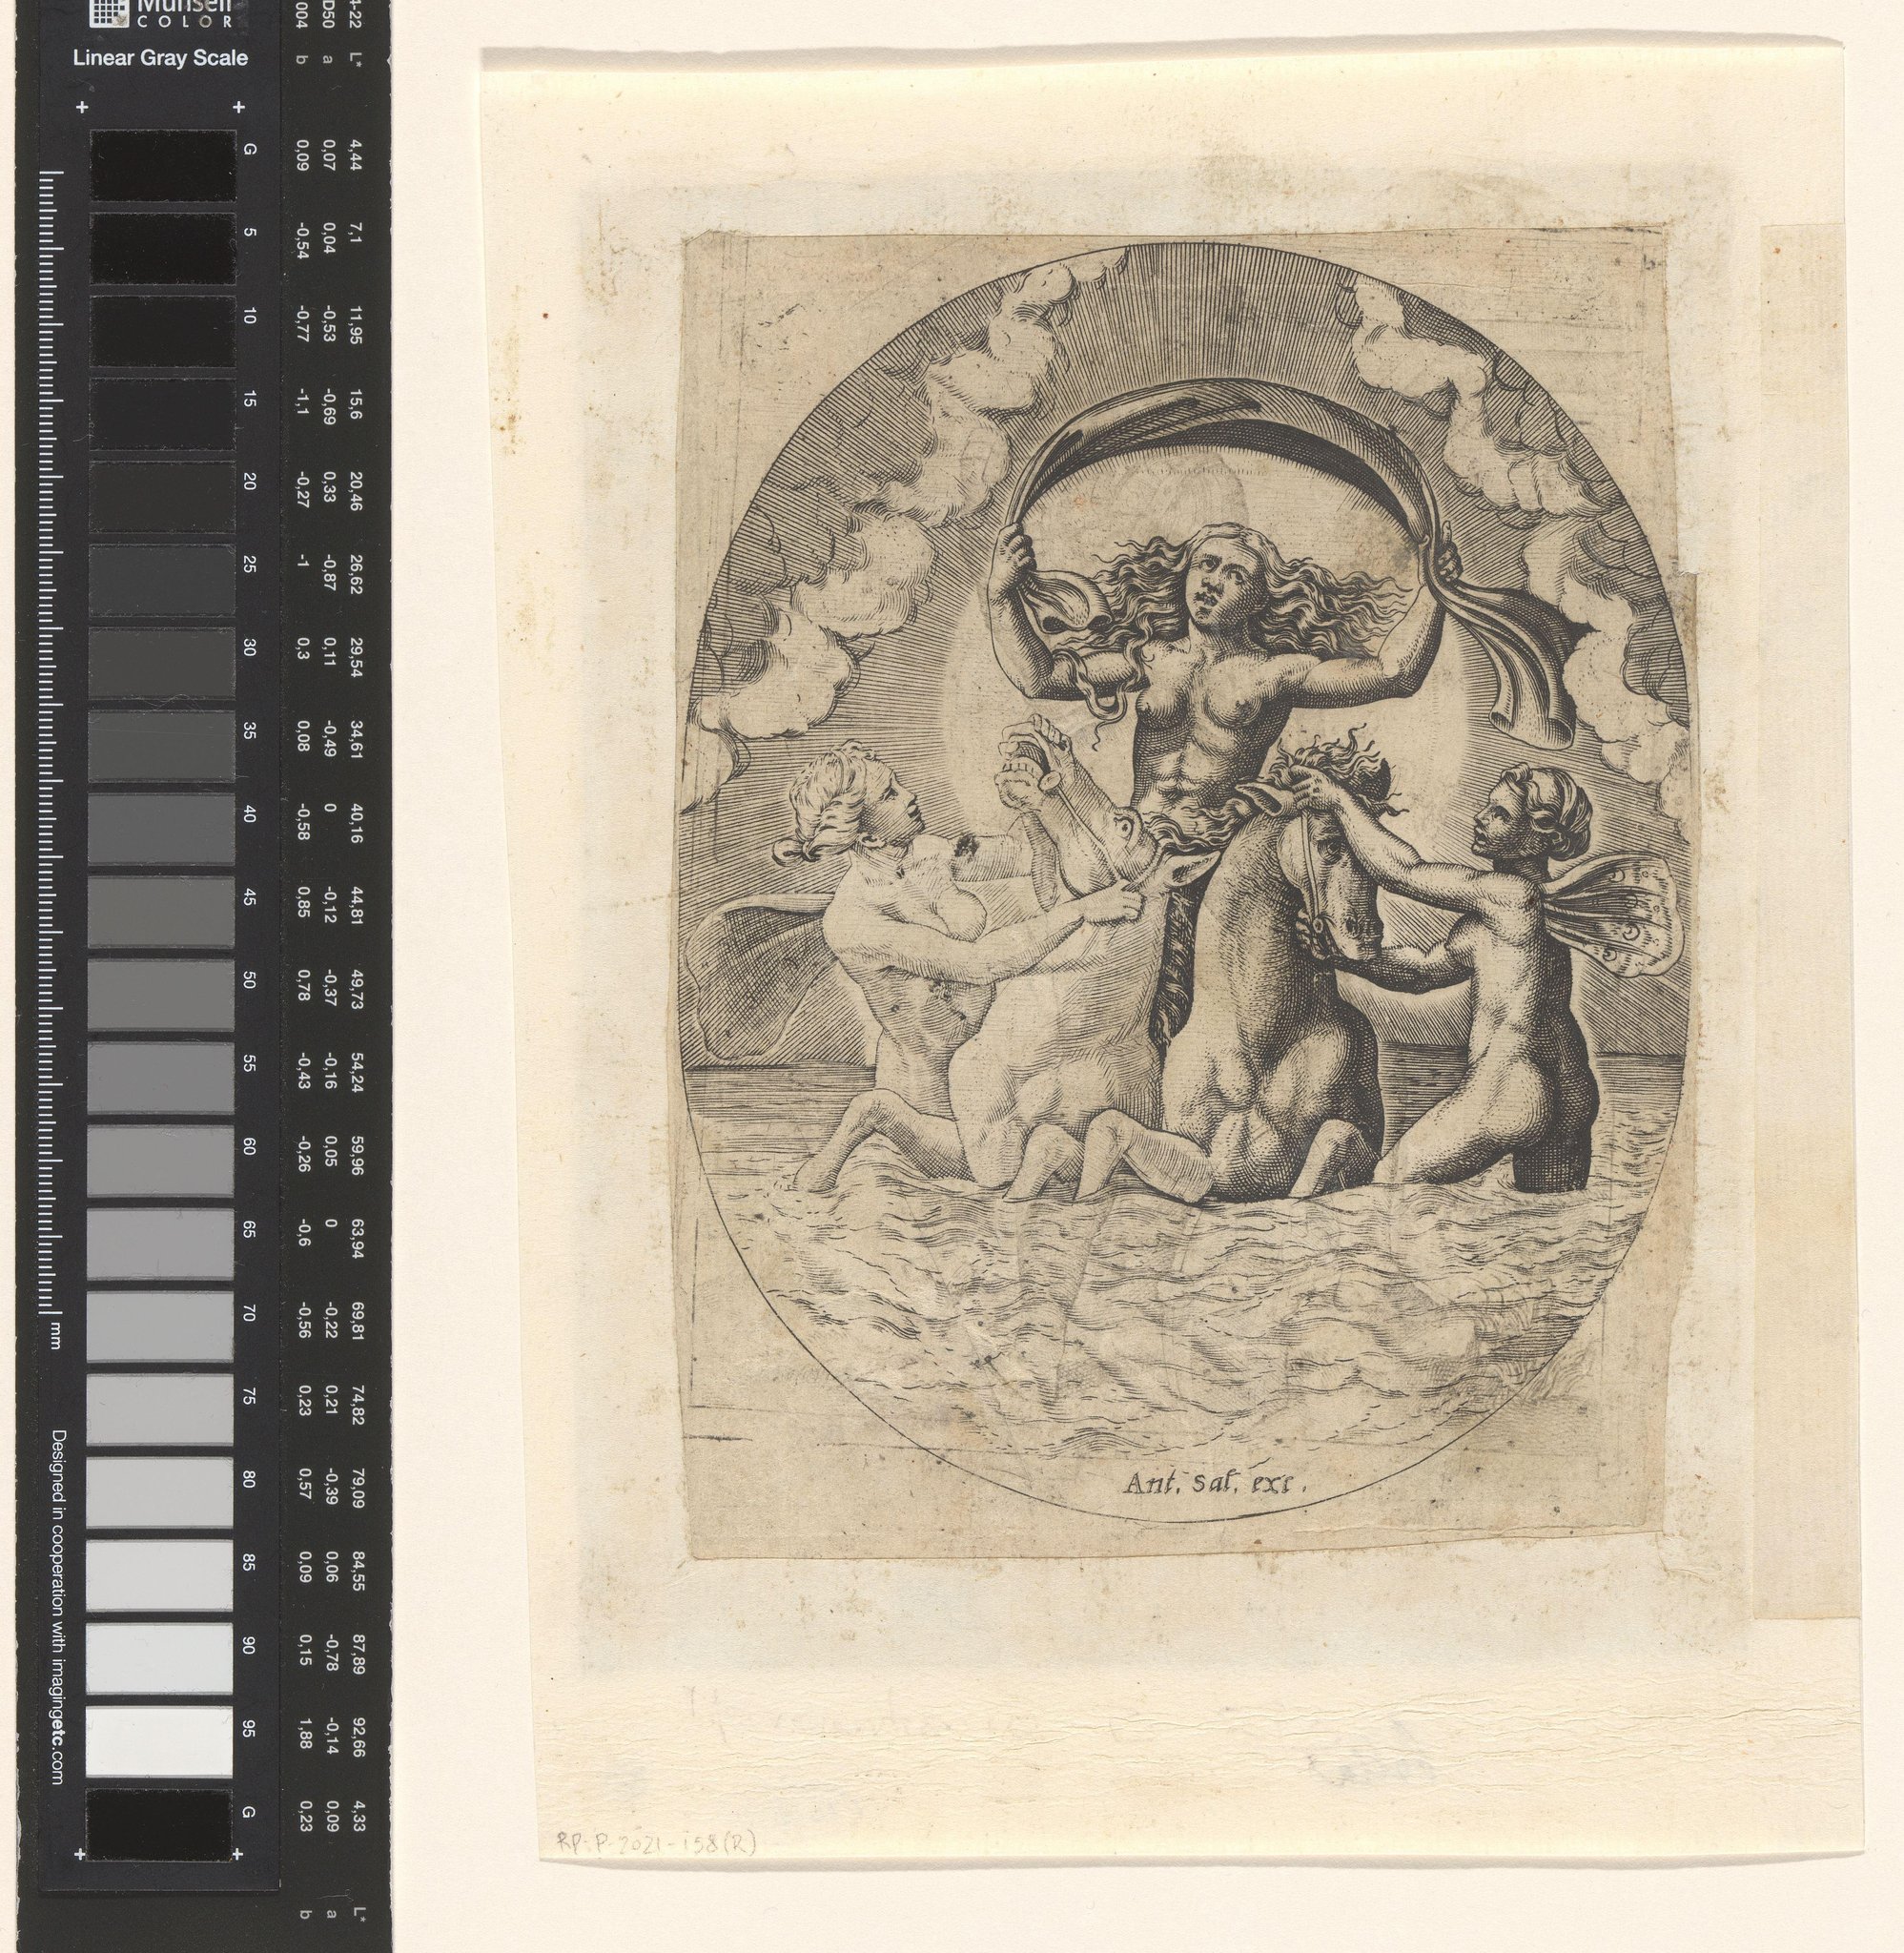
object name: print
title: Aurora (dageraad)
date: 1509-1536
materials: paper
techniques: engraving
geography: rome